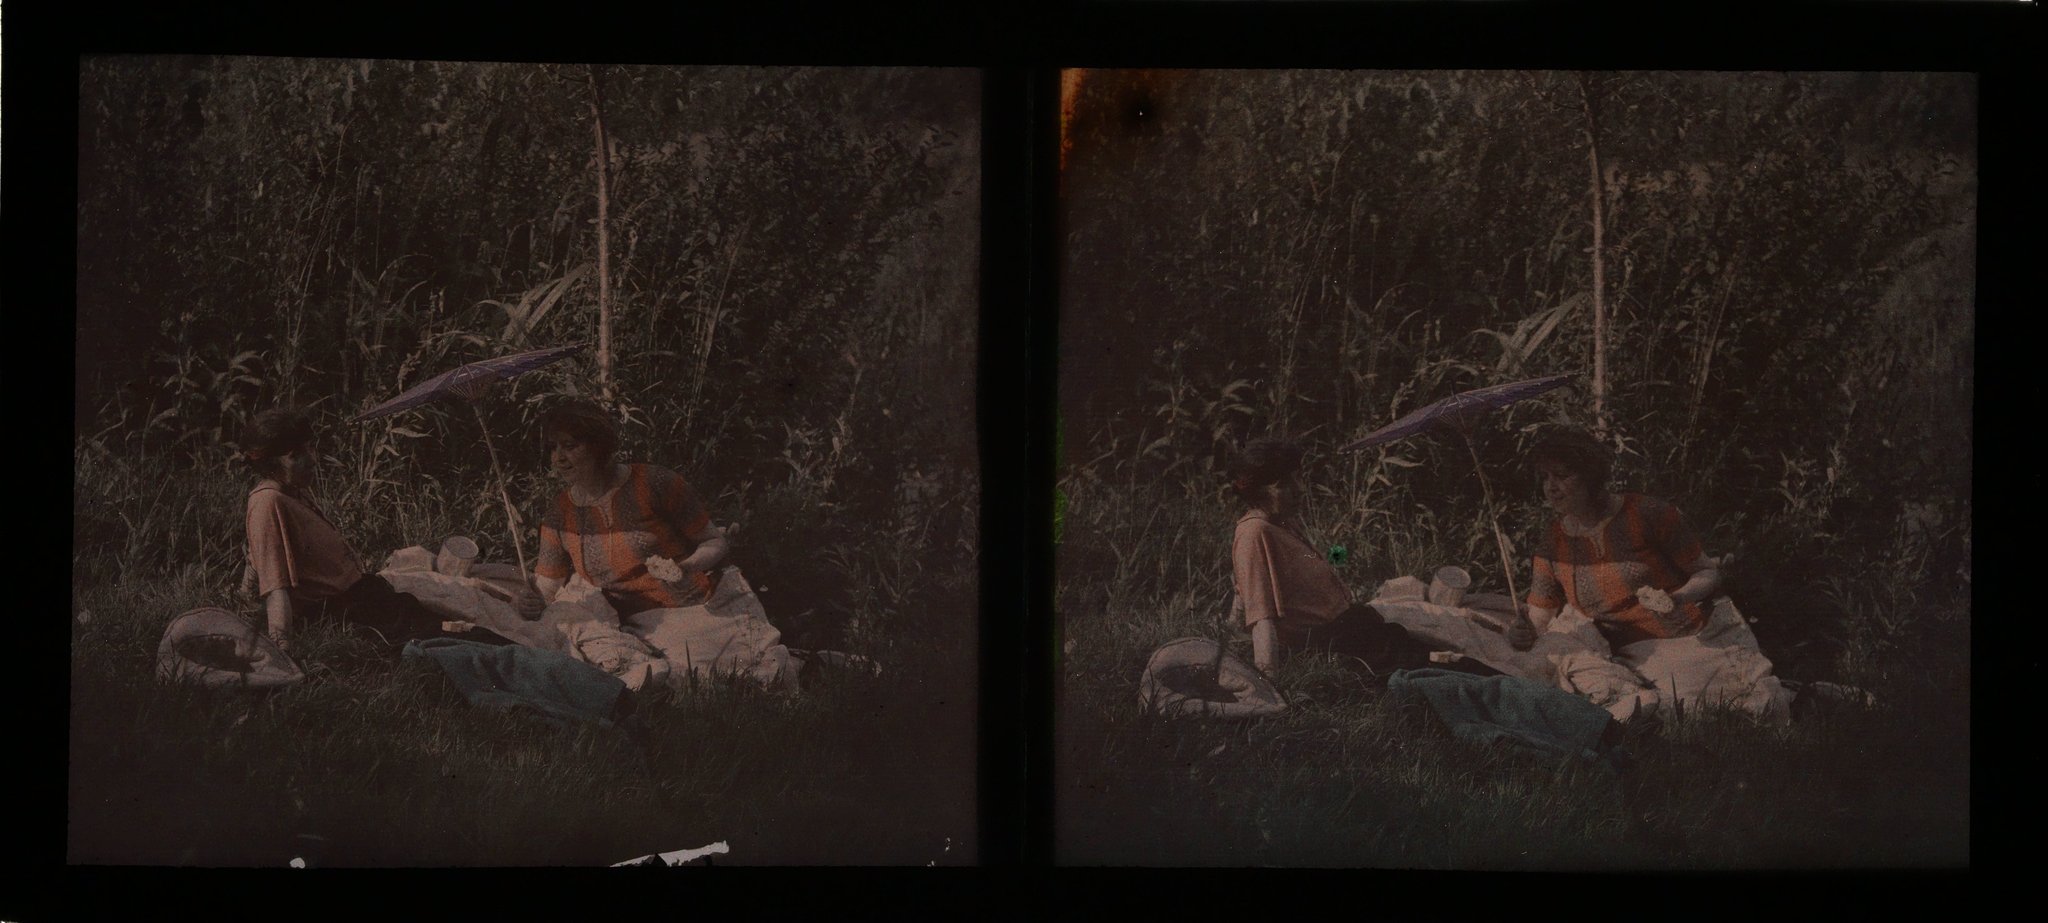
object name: stereograph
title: Twee vrouwen aan het picknicken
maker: Anonymous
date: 1910-1940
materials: glass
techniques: autochrome process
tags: midday meal, lunch - cc - out of doors